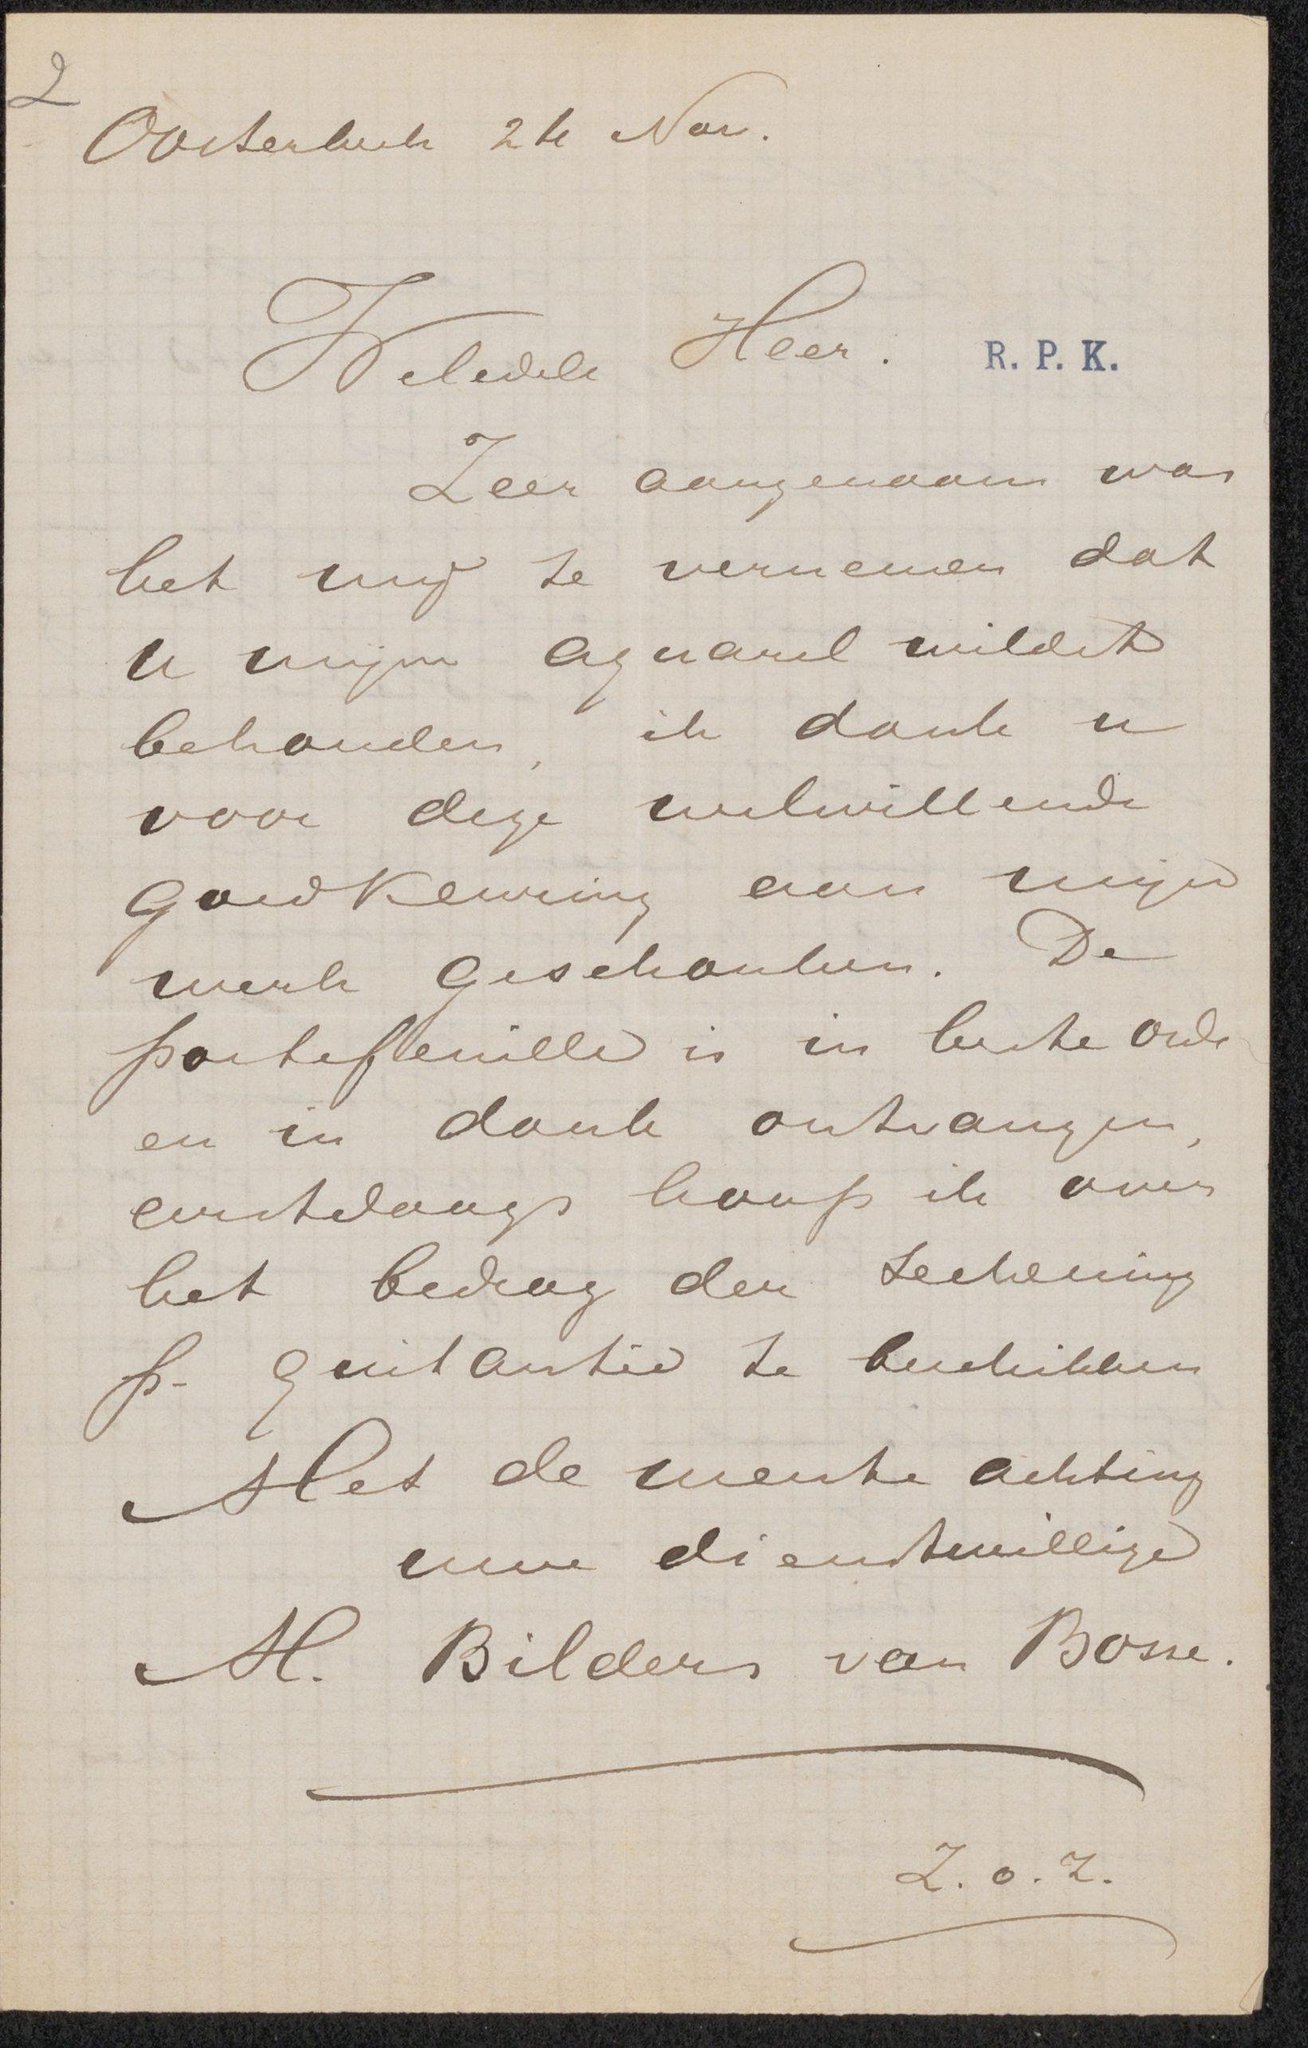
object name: letter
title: Brief aan Frans Buffa en Zonen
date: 1880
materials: ink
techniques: pen, writing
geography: oosterbeek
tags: publisher, drawing, the graphic arts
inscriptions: collector's mark: Lugt 2233